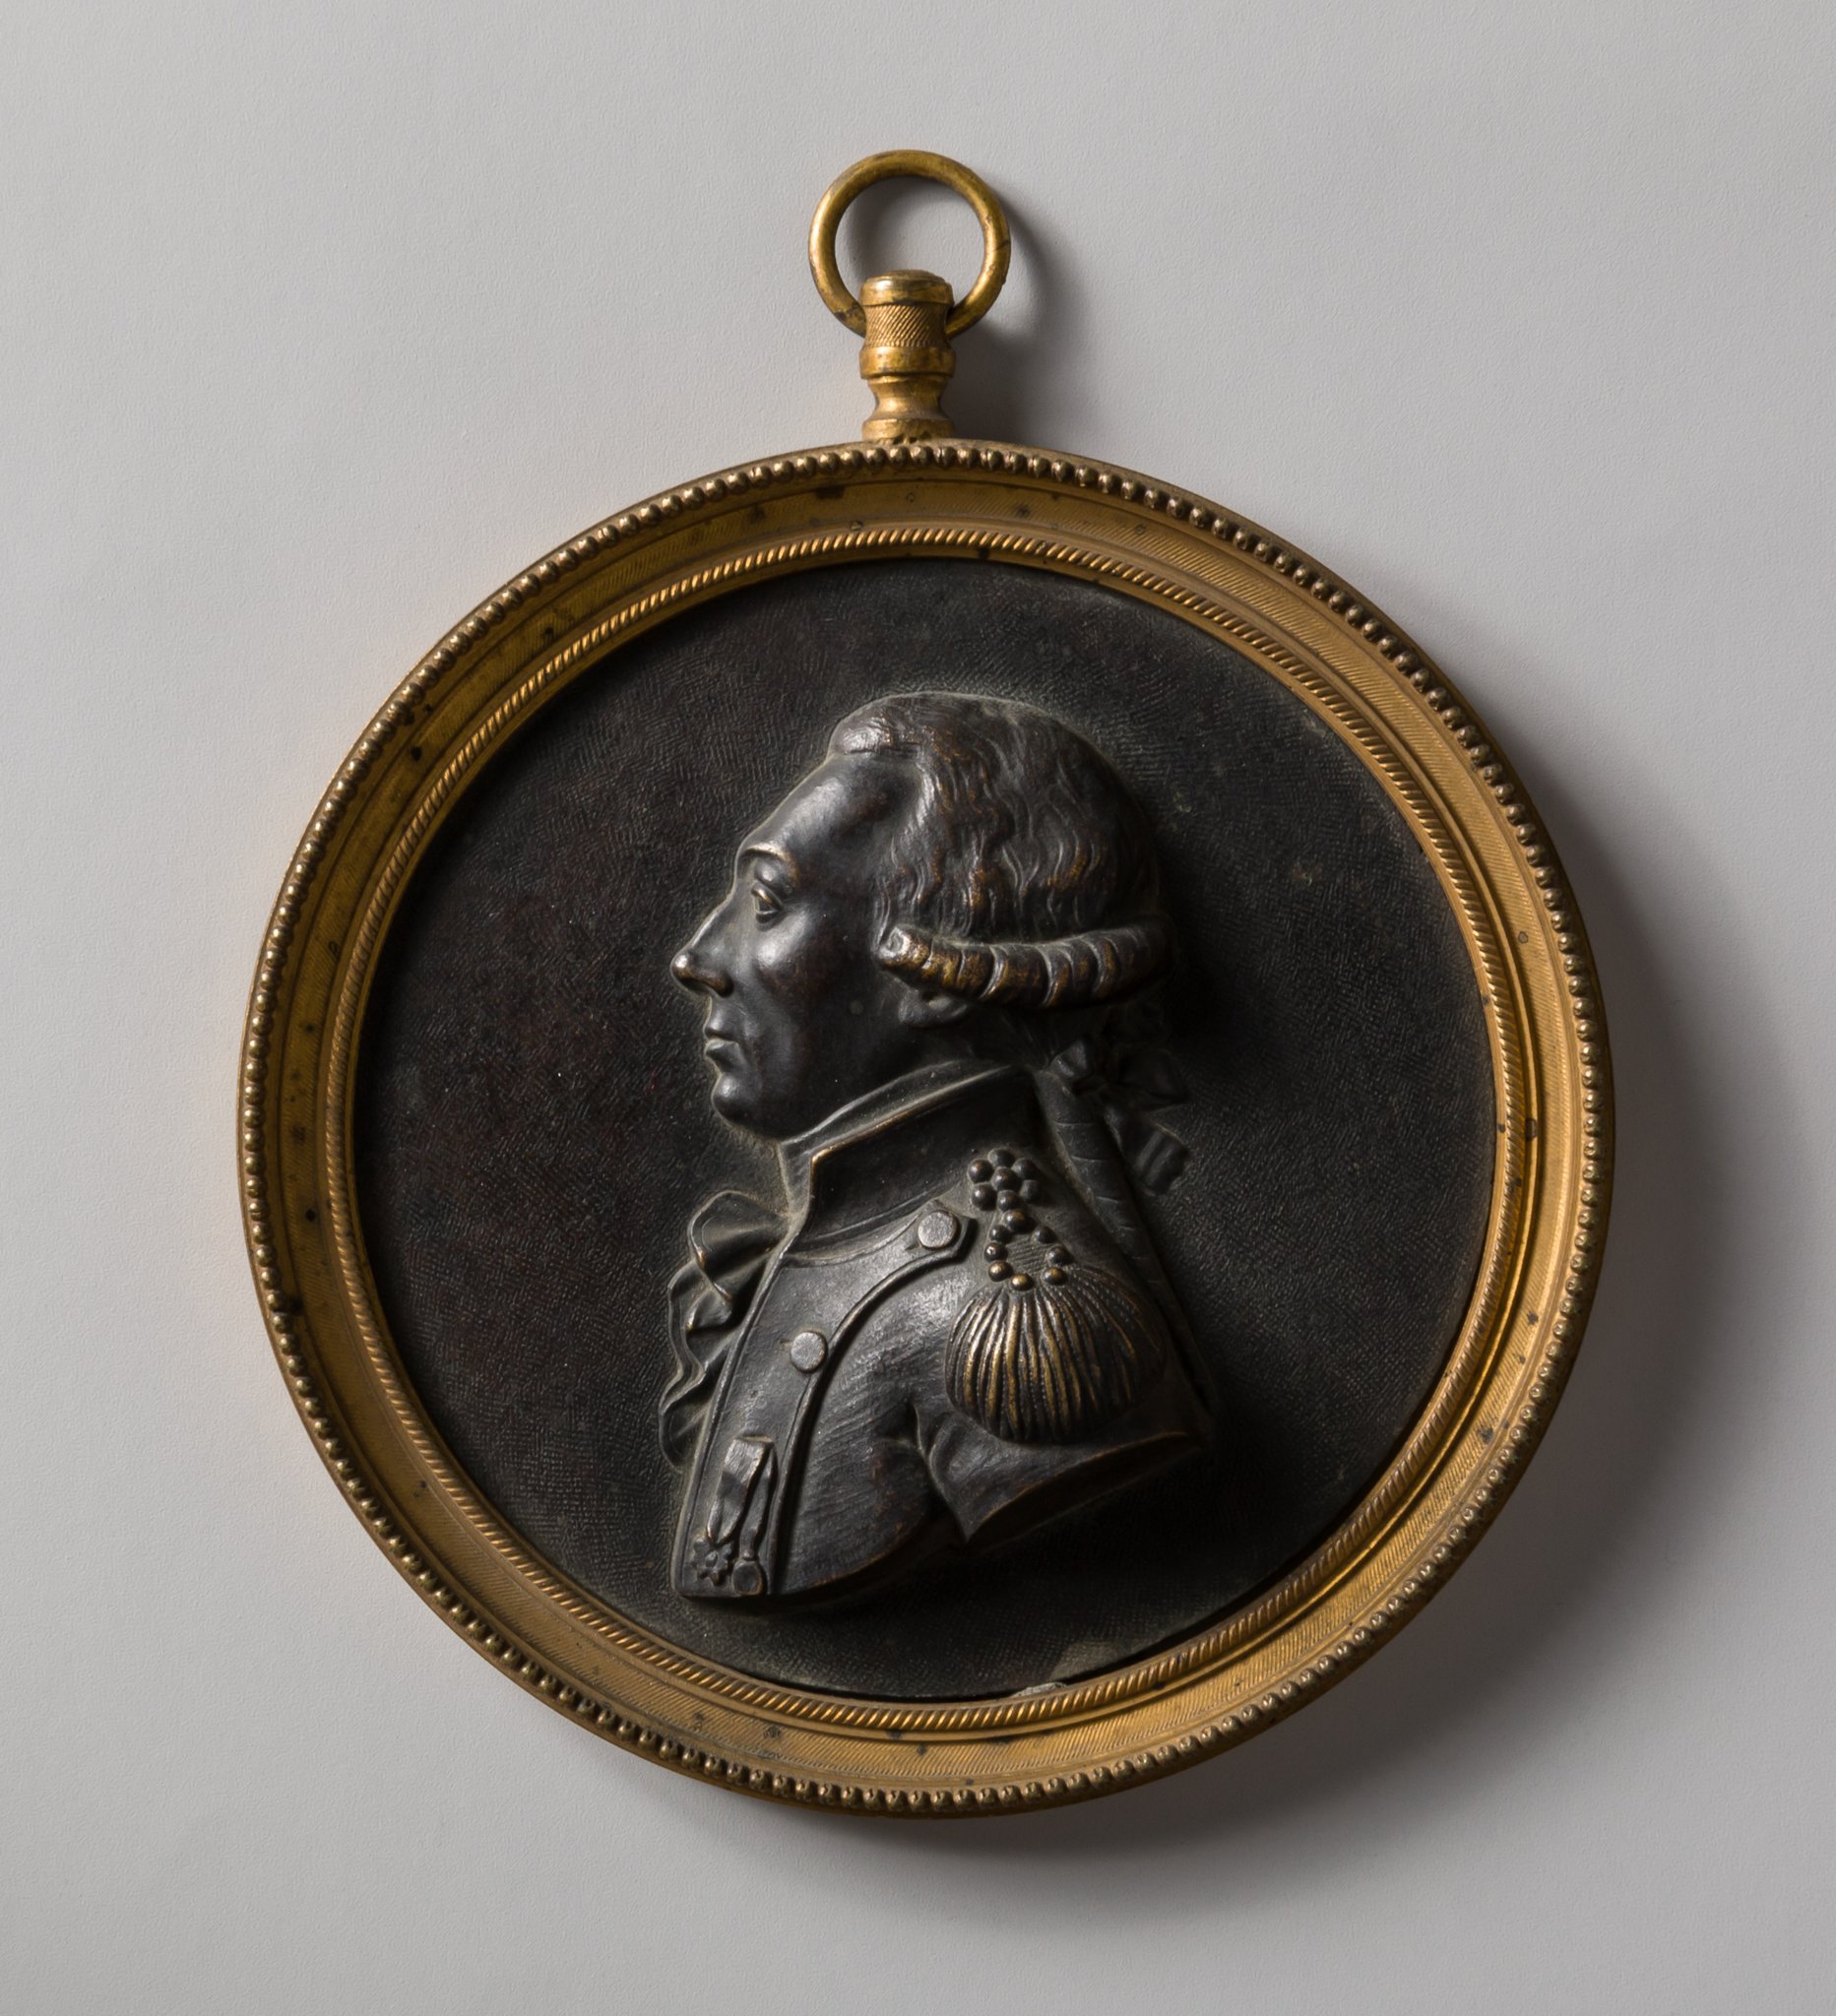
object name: medallion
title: Medallion of the Marquis de Lafayette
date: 1775-1800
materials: bronze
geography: france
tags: men,profiles,marquis de lafayette